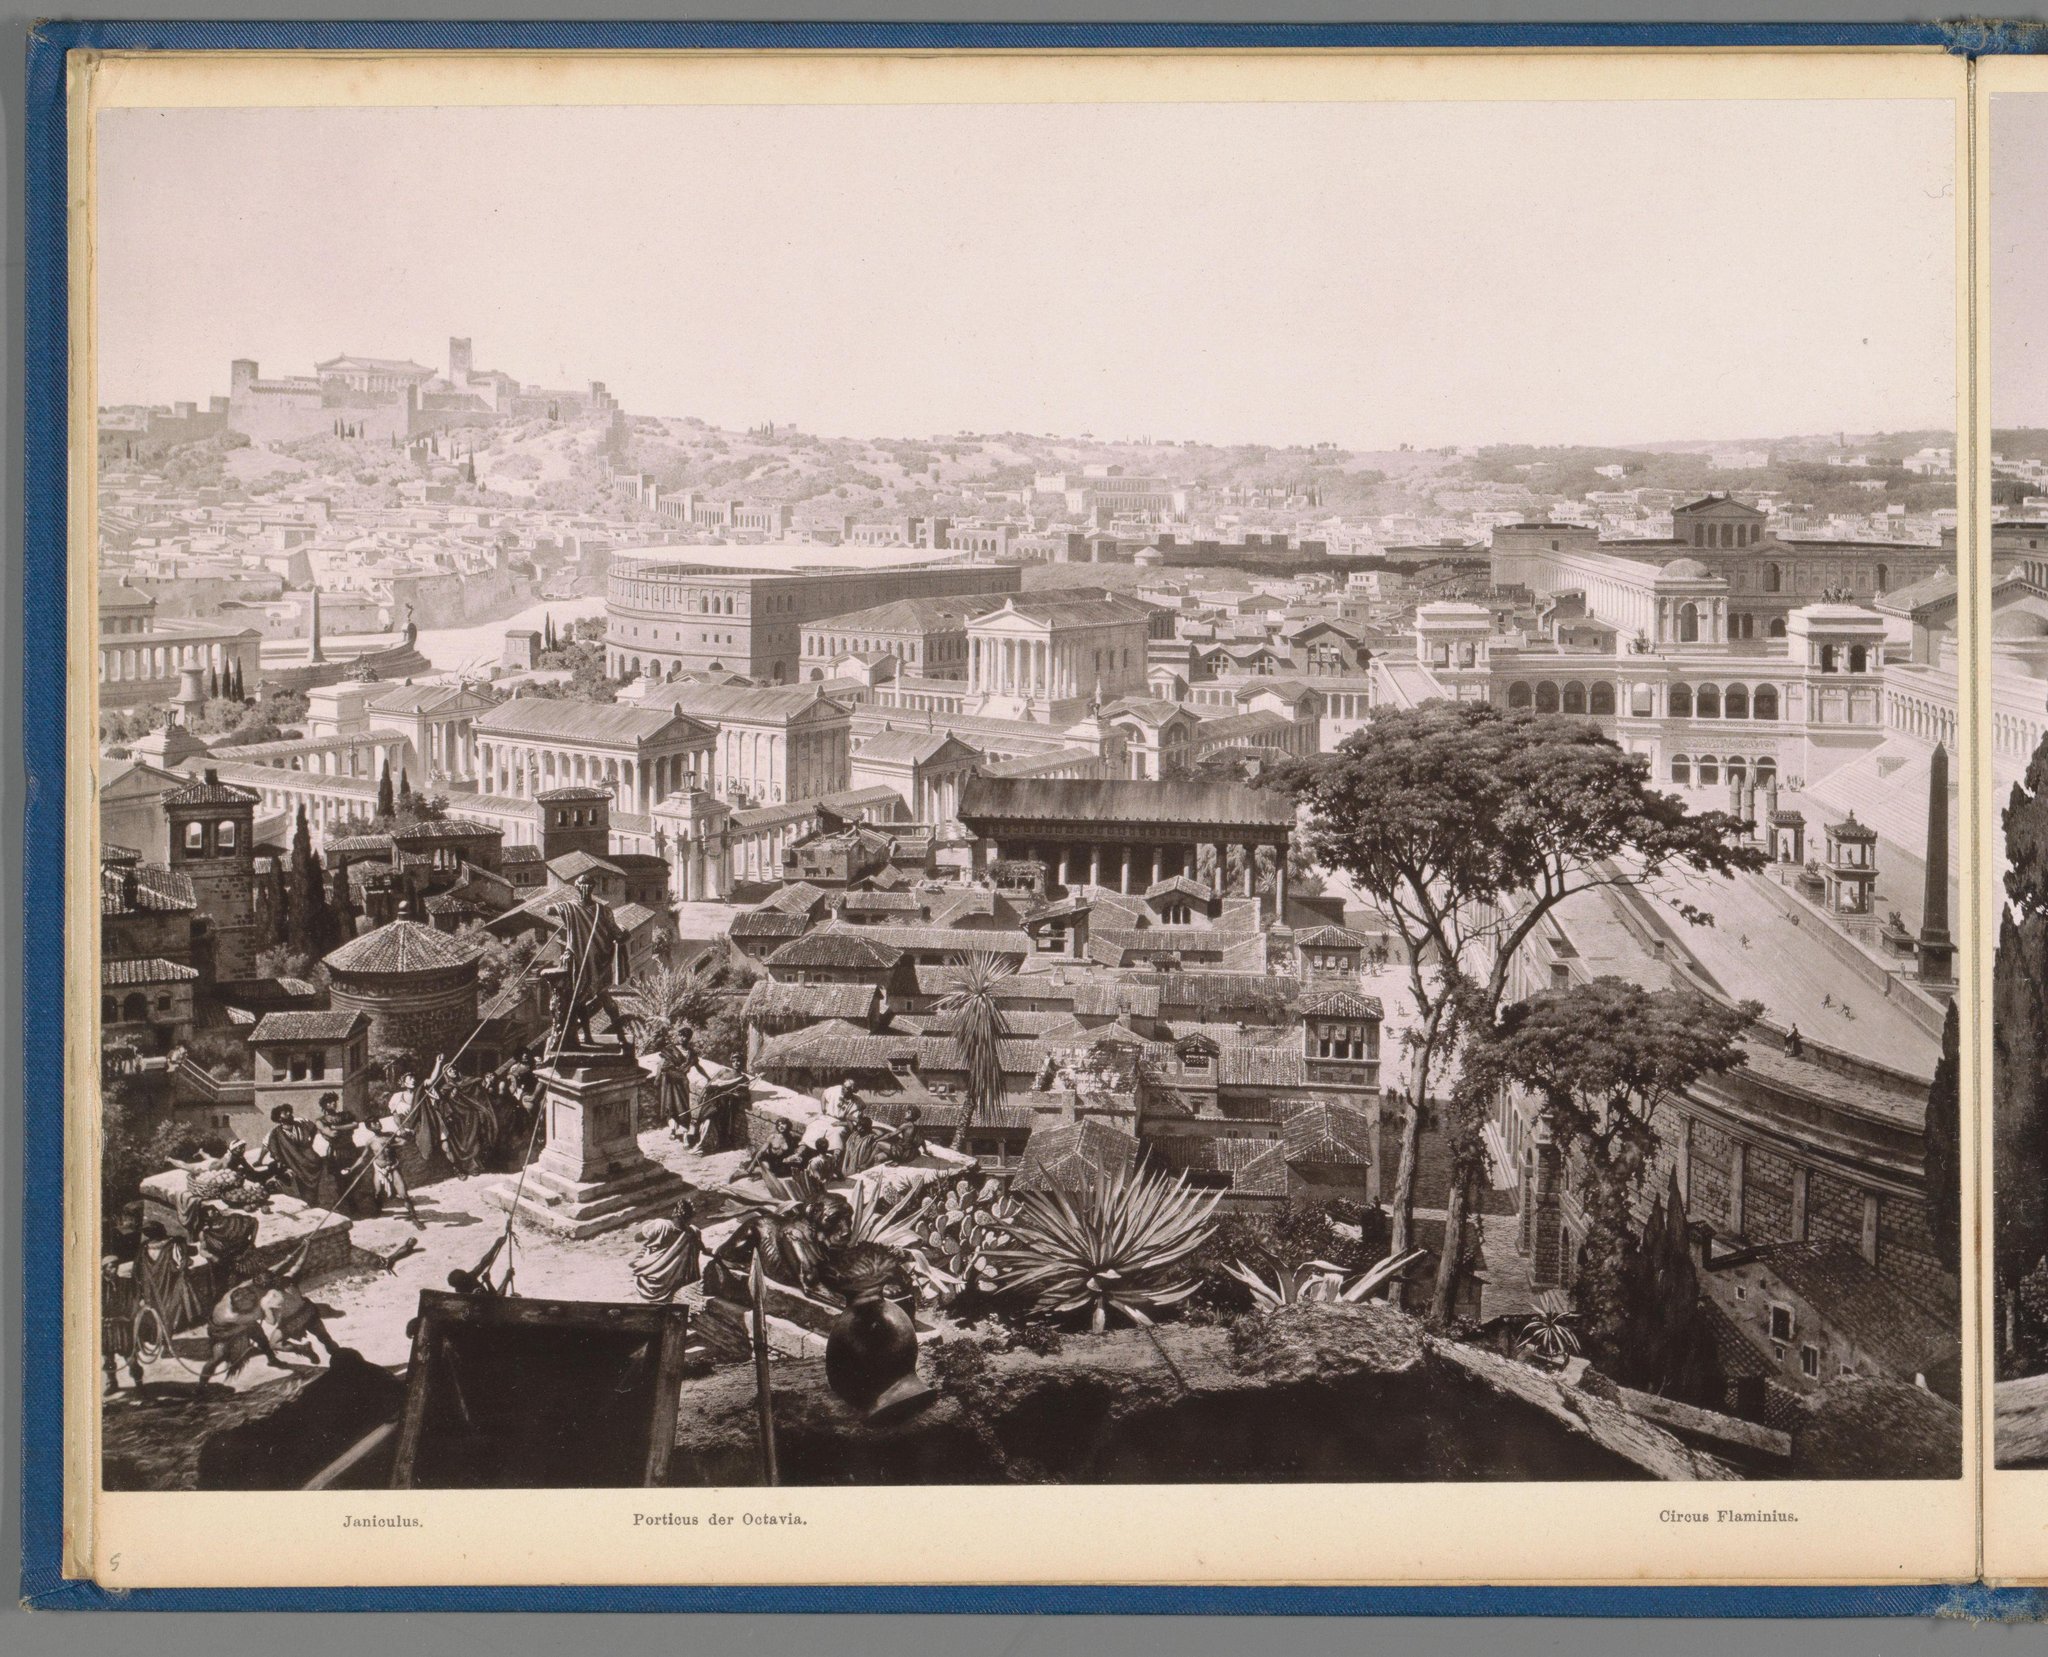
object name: photograph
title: Janiculus. - Porticus der Octavia. - Circus Flaminius.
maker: franz seraph hanfstaengl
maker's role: painter, print maker, printer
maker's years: 1804-1877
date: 1890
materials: cardboard, paper, ink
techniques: photograph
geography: munich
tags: (high) hill, courtyard, exterior ~ representation of a building, square, place, circus, etc. (+ city(-scape) with figures, staffage), prospect of city, town panorama, silhouette of city, rome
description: Onderdeel van Panorama van het oude Rome.